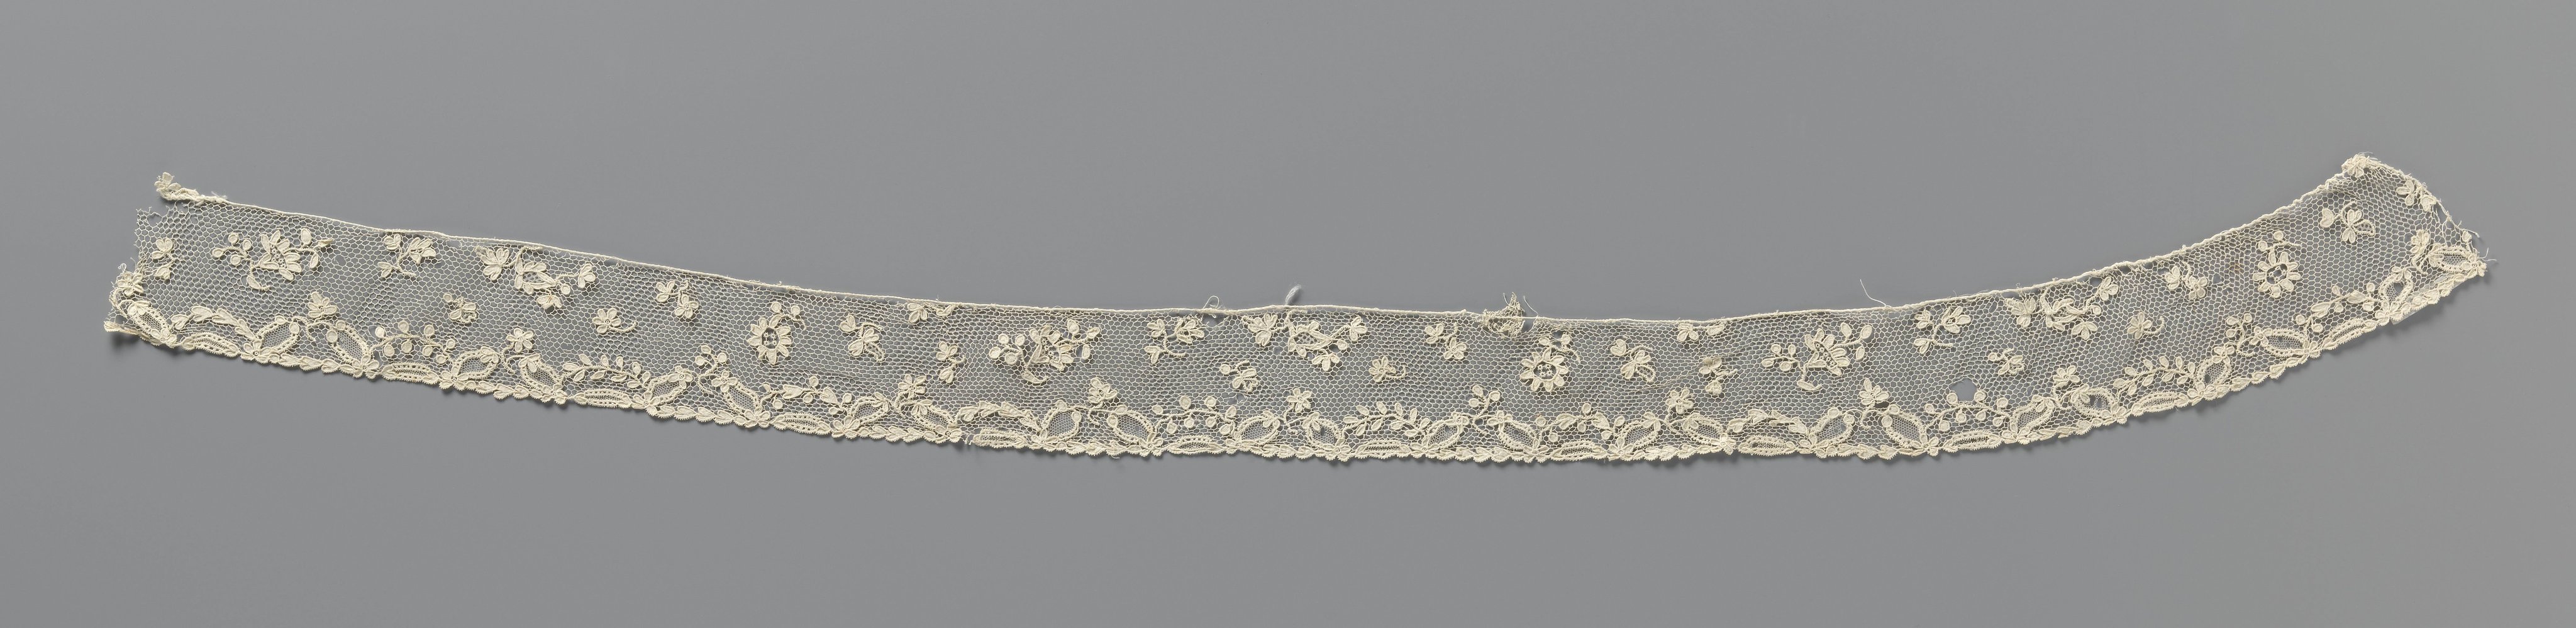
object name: strip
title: Strook naaldkant met bloemenstrooipatroon en spitsovaaltjes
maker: Anonymous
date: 1775-1799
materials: linen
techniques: lace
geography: argentan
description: Strook naturelkleurig naaldkant, Argentankant. Strooipatroon van takjes waaraan afwisselend een kleine of grotere bloem, blaadjes en/of besjes. Grond met mazen die dicht omnaaid zijn met knoopsgatensteken. Het patroon langs de onderrand bestaat uit steeds twee naar elkaar toegerichte spitsovaaltjes waartussen een bloem- of bessentakje ontspringt. De ovaalparen zijn met elkaar verbonden door een boogje van blaadjes en/of besjes en hartjes. Onder deze boogjes langs de onderrand een plat, liggend ovaaltje. De ovaalvormige figuren in het patroon zijn gevuld met een fijne zeshoekige maasgrond (Alençongrond). Verschillende siergronden in de bloemen. Volwerk zonder uitsparingen in bloemen, bladeren en bessen. Schulpenrand aan de onderzijde door een aaneenschakeling van hartvormige blaadjes, op regelmatige afstand onderbroken door een rozetbloempje en het platte liggende ovaaltje. De bovenzijde is afgewerkt met een rechte rand.